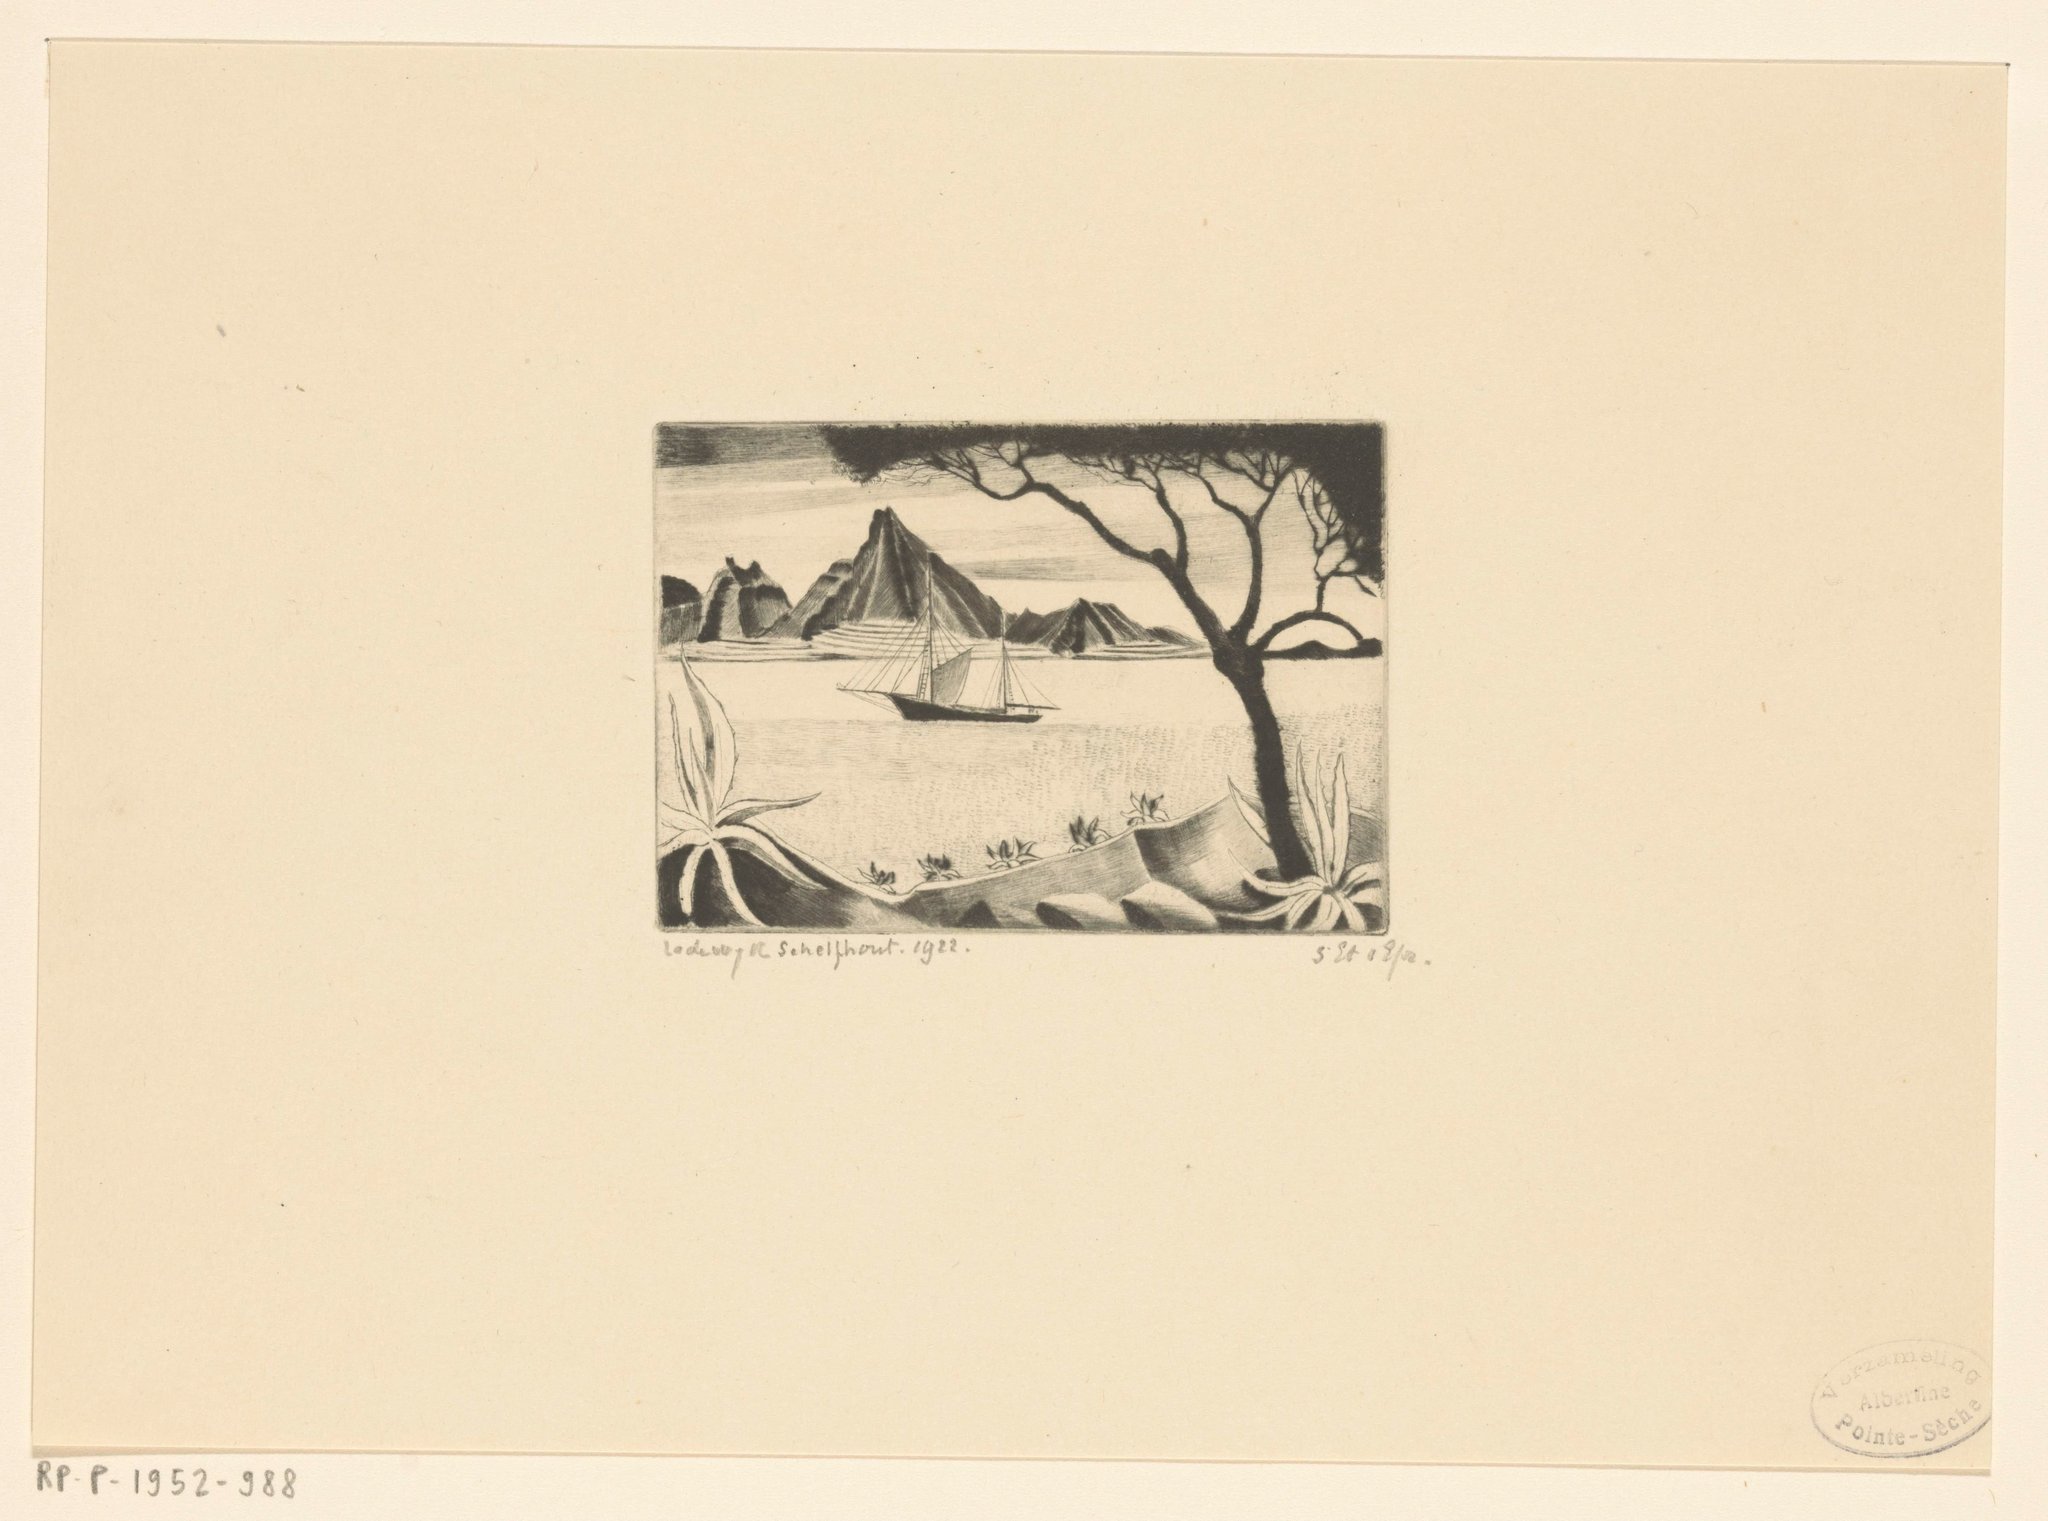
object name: print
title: Zeilschip in een baai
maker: lodewijk schelfhout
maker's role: draughtsman, print maker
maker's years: 1881-1943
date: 1922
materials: paper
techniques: drypoint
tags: sailing-ship, sailing-boat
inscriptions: collector's mark: Lugt 2228, collector's mark: Lugt 5i, collector's mark: Lugt 2760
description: Op de voorgrond een boom, op de achtergrond bergen.